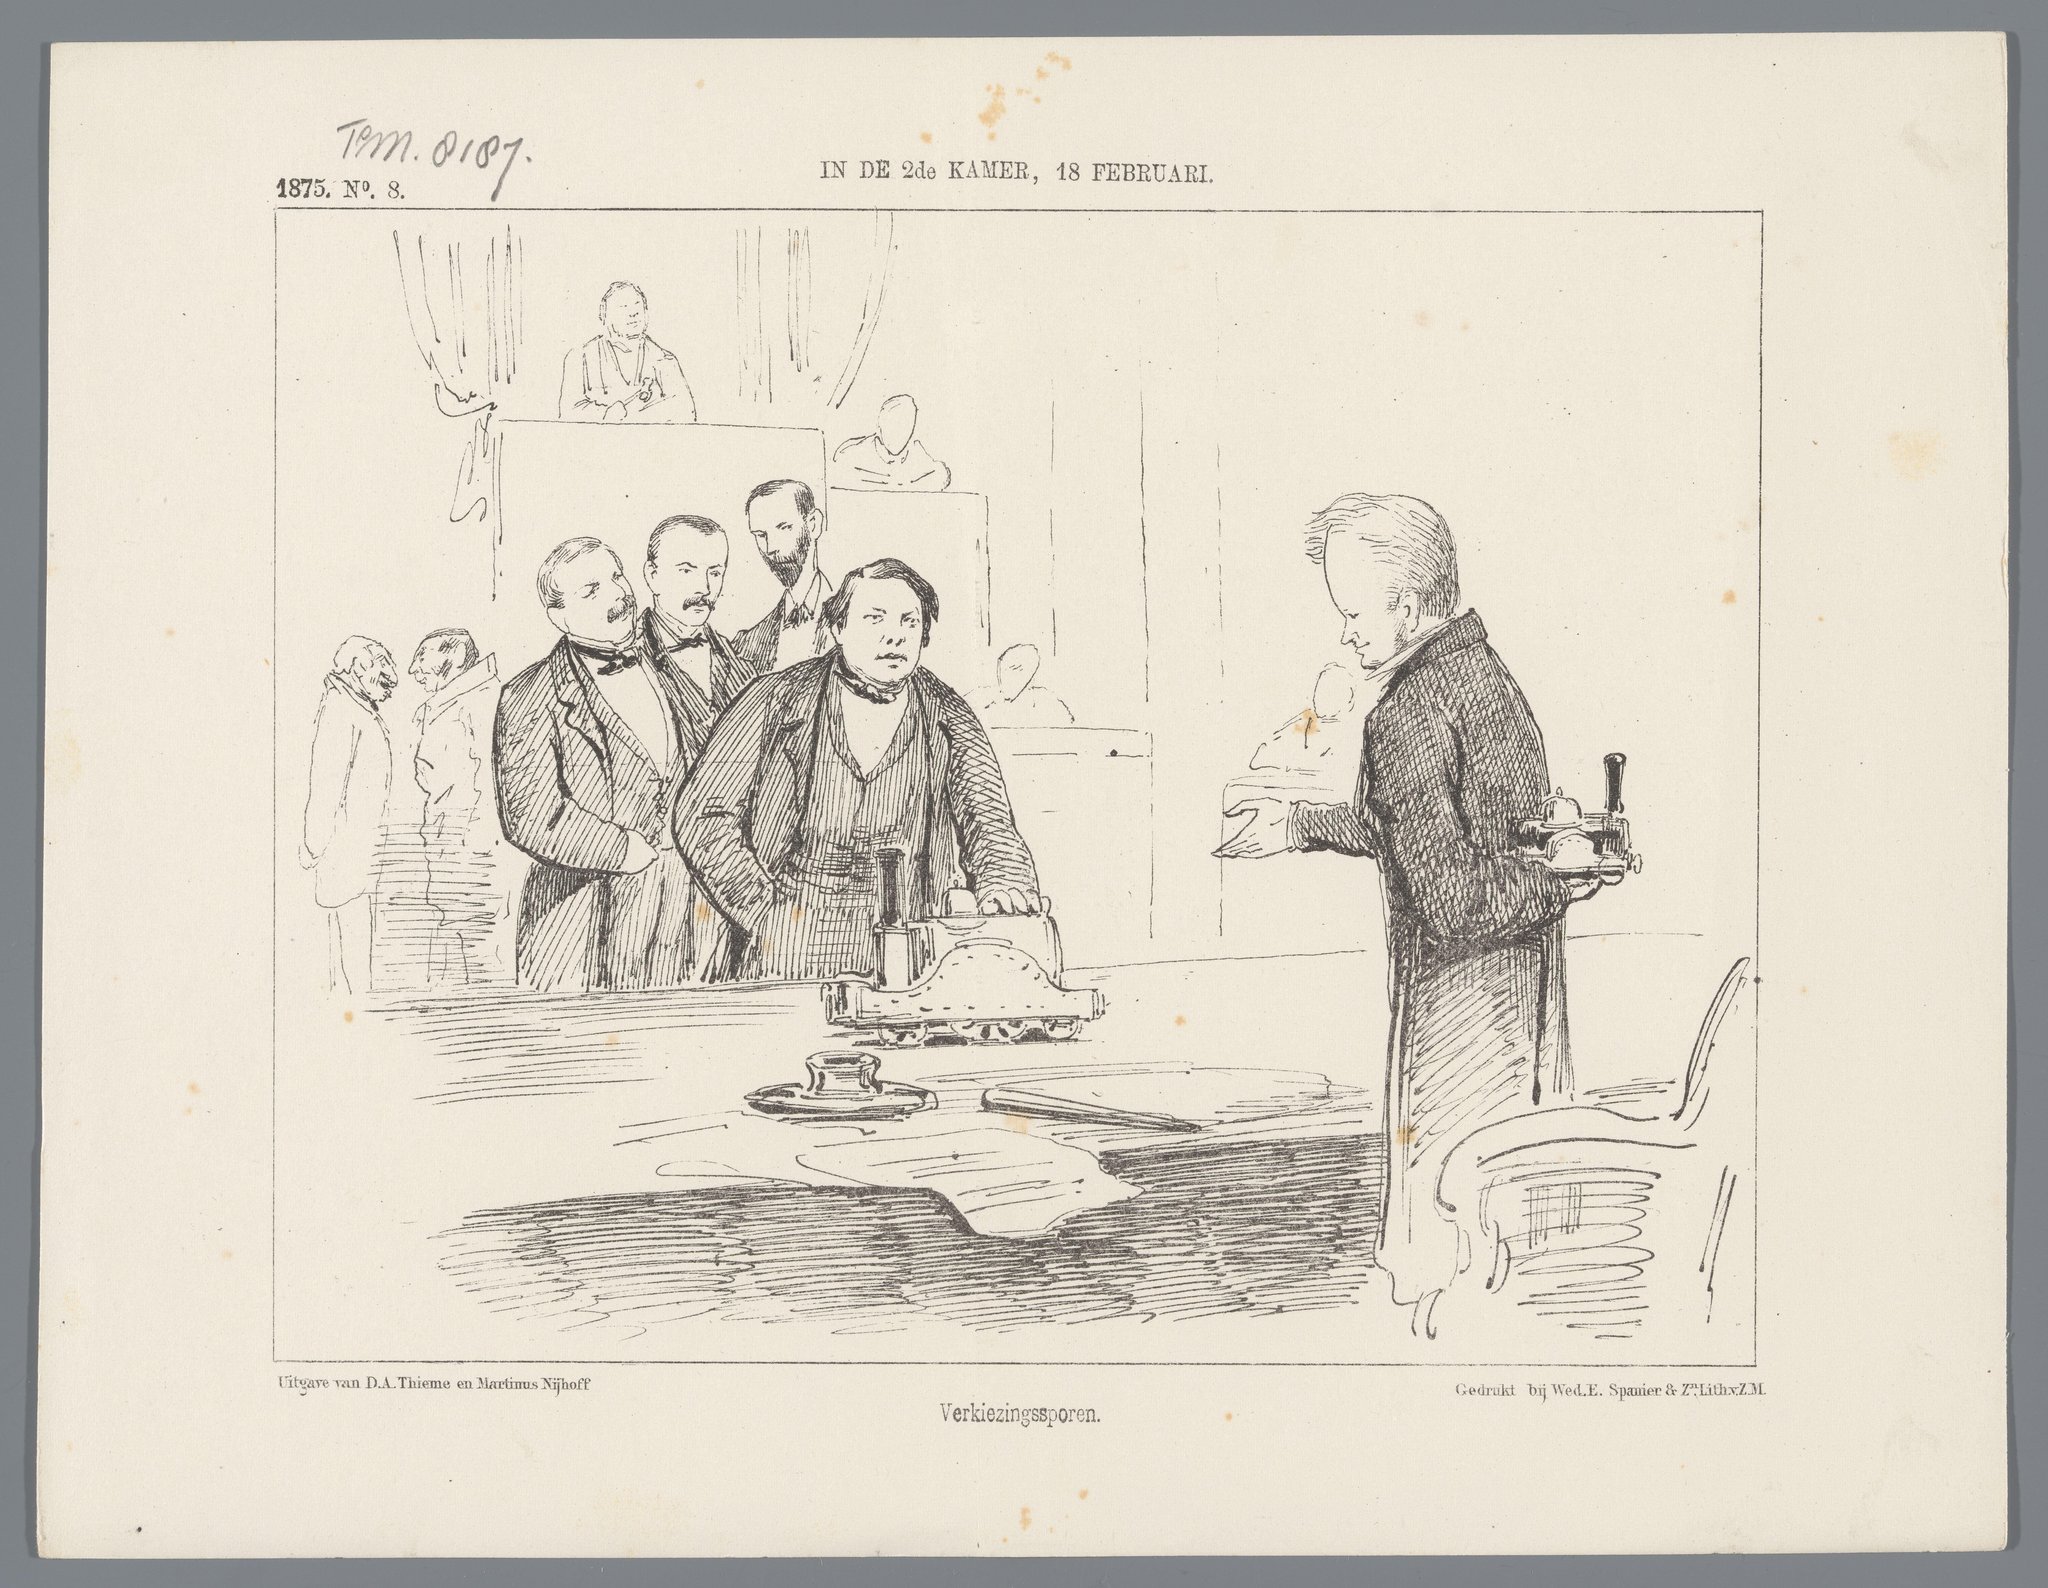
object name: cartoon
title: Spotprent op het wetsvoorstel voor nieuwe spoorwegen, 1875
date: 1875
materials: paper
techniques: lithograph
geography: netherlands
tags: amsterdam, politician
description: Spotprent op het indienen van een wetsvoorstel tot het maken van nieuwe spoorwegen, 1875. Plaat verschenen bij het weekblad De Nederlandsche Spectator, nr. 8, 1875.